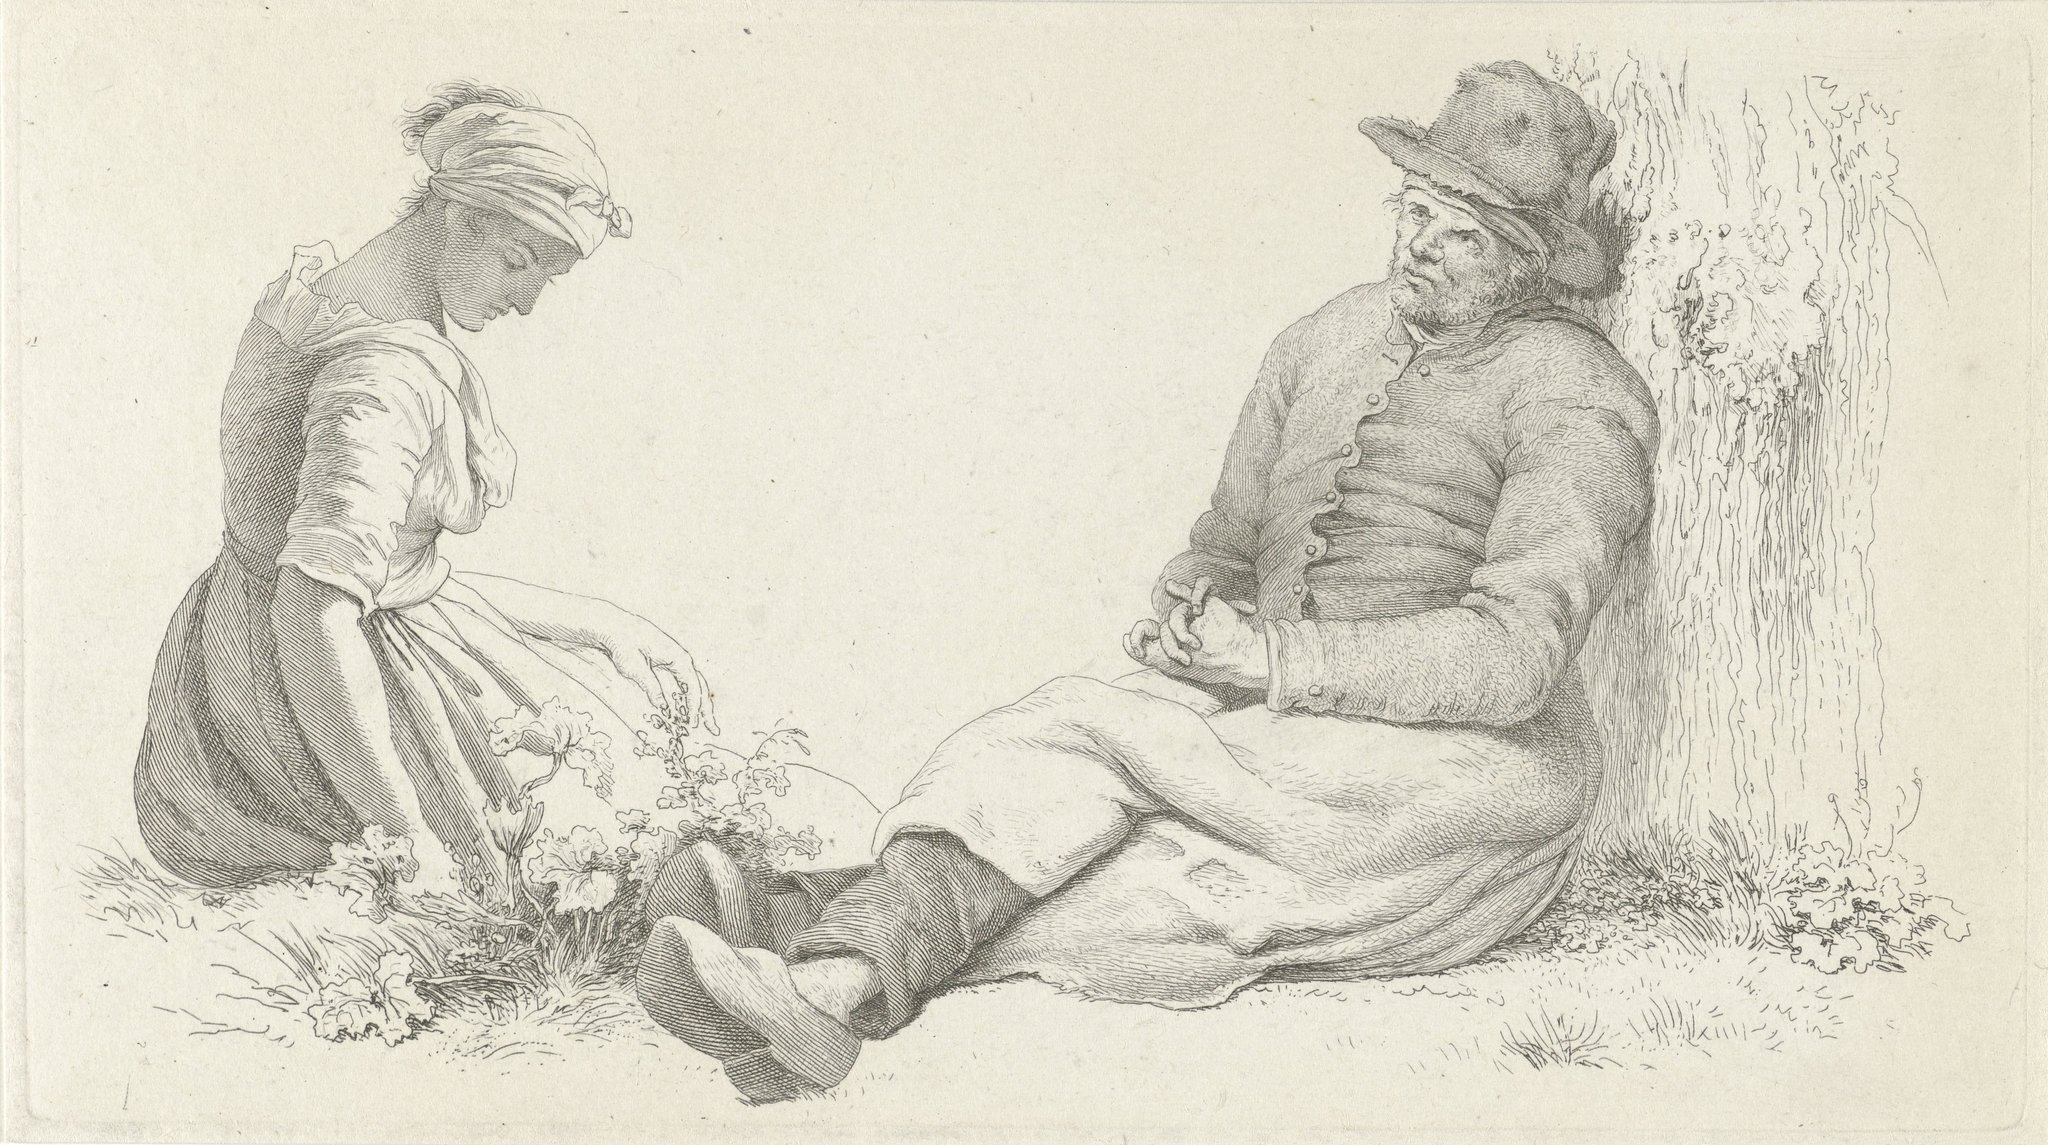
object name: print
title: Studieblad met een zittende man en een jonge vrouw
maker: jacob ernst marcus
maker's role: draughtsman, print maker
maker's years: 1774-1826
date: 1801-1808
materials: paper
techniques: etching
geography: amsterdam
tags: adolescent, young woman, maiden (+ sitting), old man (+ sitting)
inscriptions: collector's mark: Lugt 2228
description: Serie voor het eerst uitgegeven door Jacob Ernst Marcus onder de titel Studiebeelden en Fragmenten. Amsterdam: ca.1816. Later heruitgegeven als: Studie-prentwerk/ Etudes gravées.